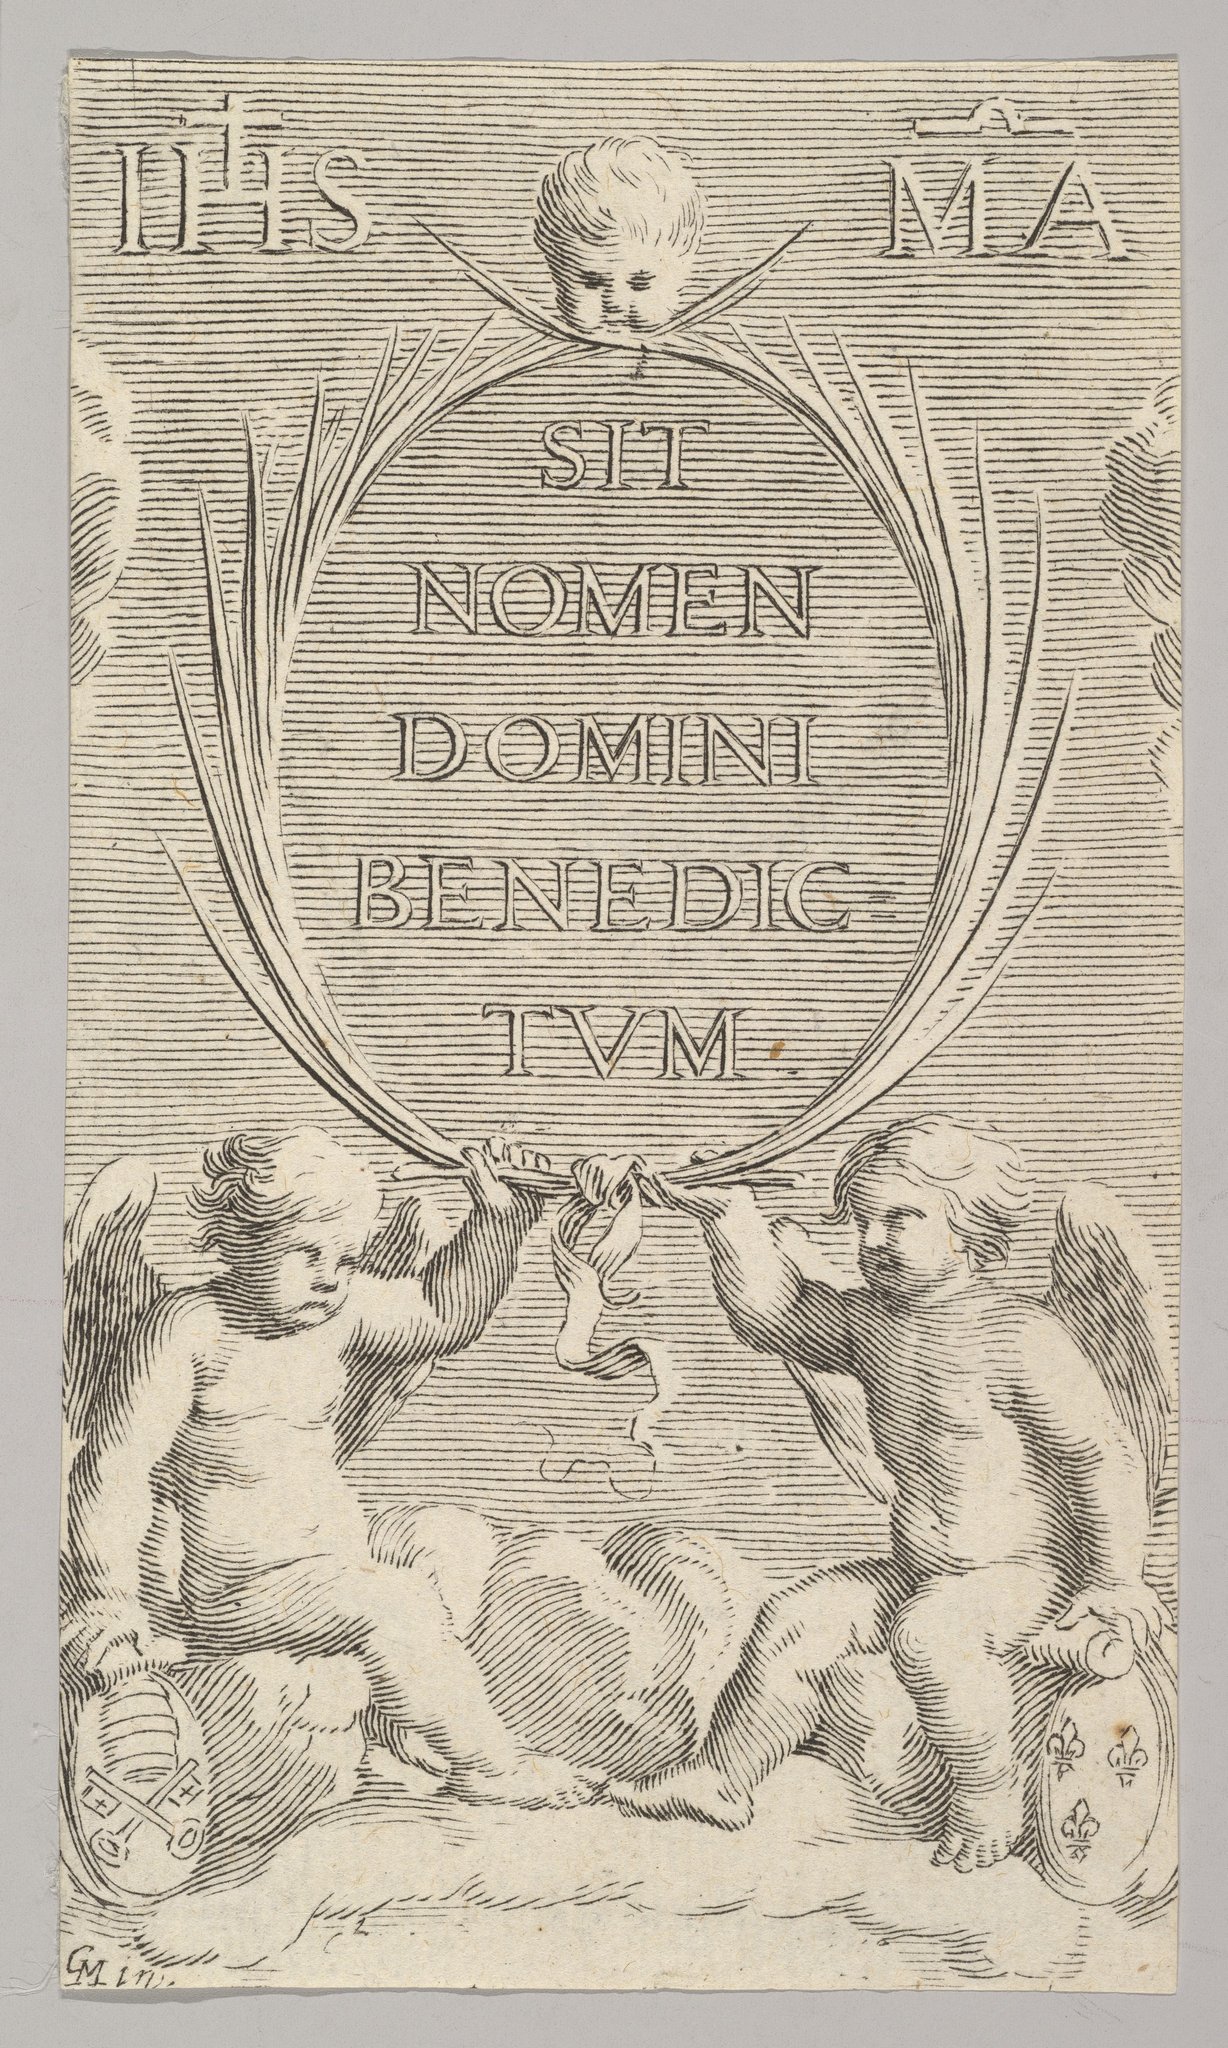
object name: print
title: Two Angels Seated on Clouds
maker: claude mellan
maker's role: artist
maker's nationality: french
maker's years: 1598-1688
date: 1600-1688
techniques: etching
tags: angels,coat of arms